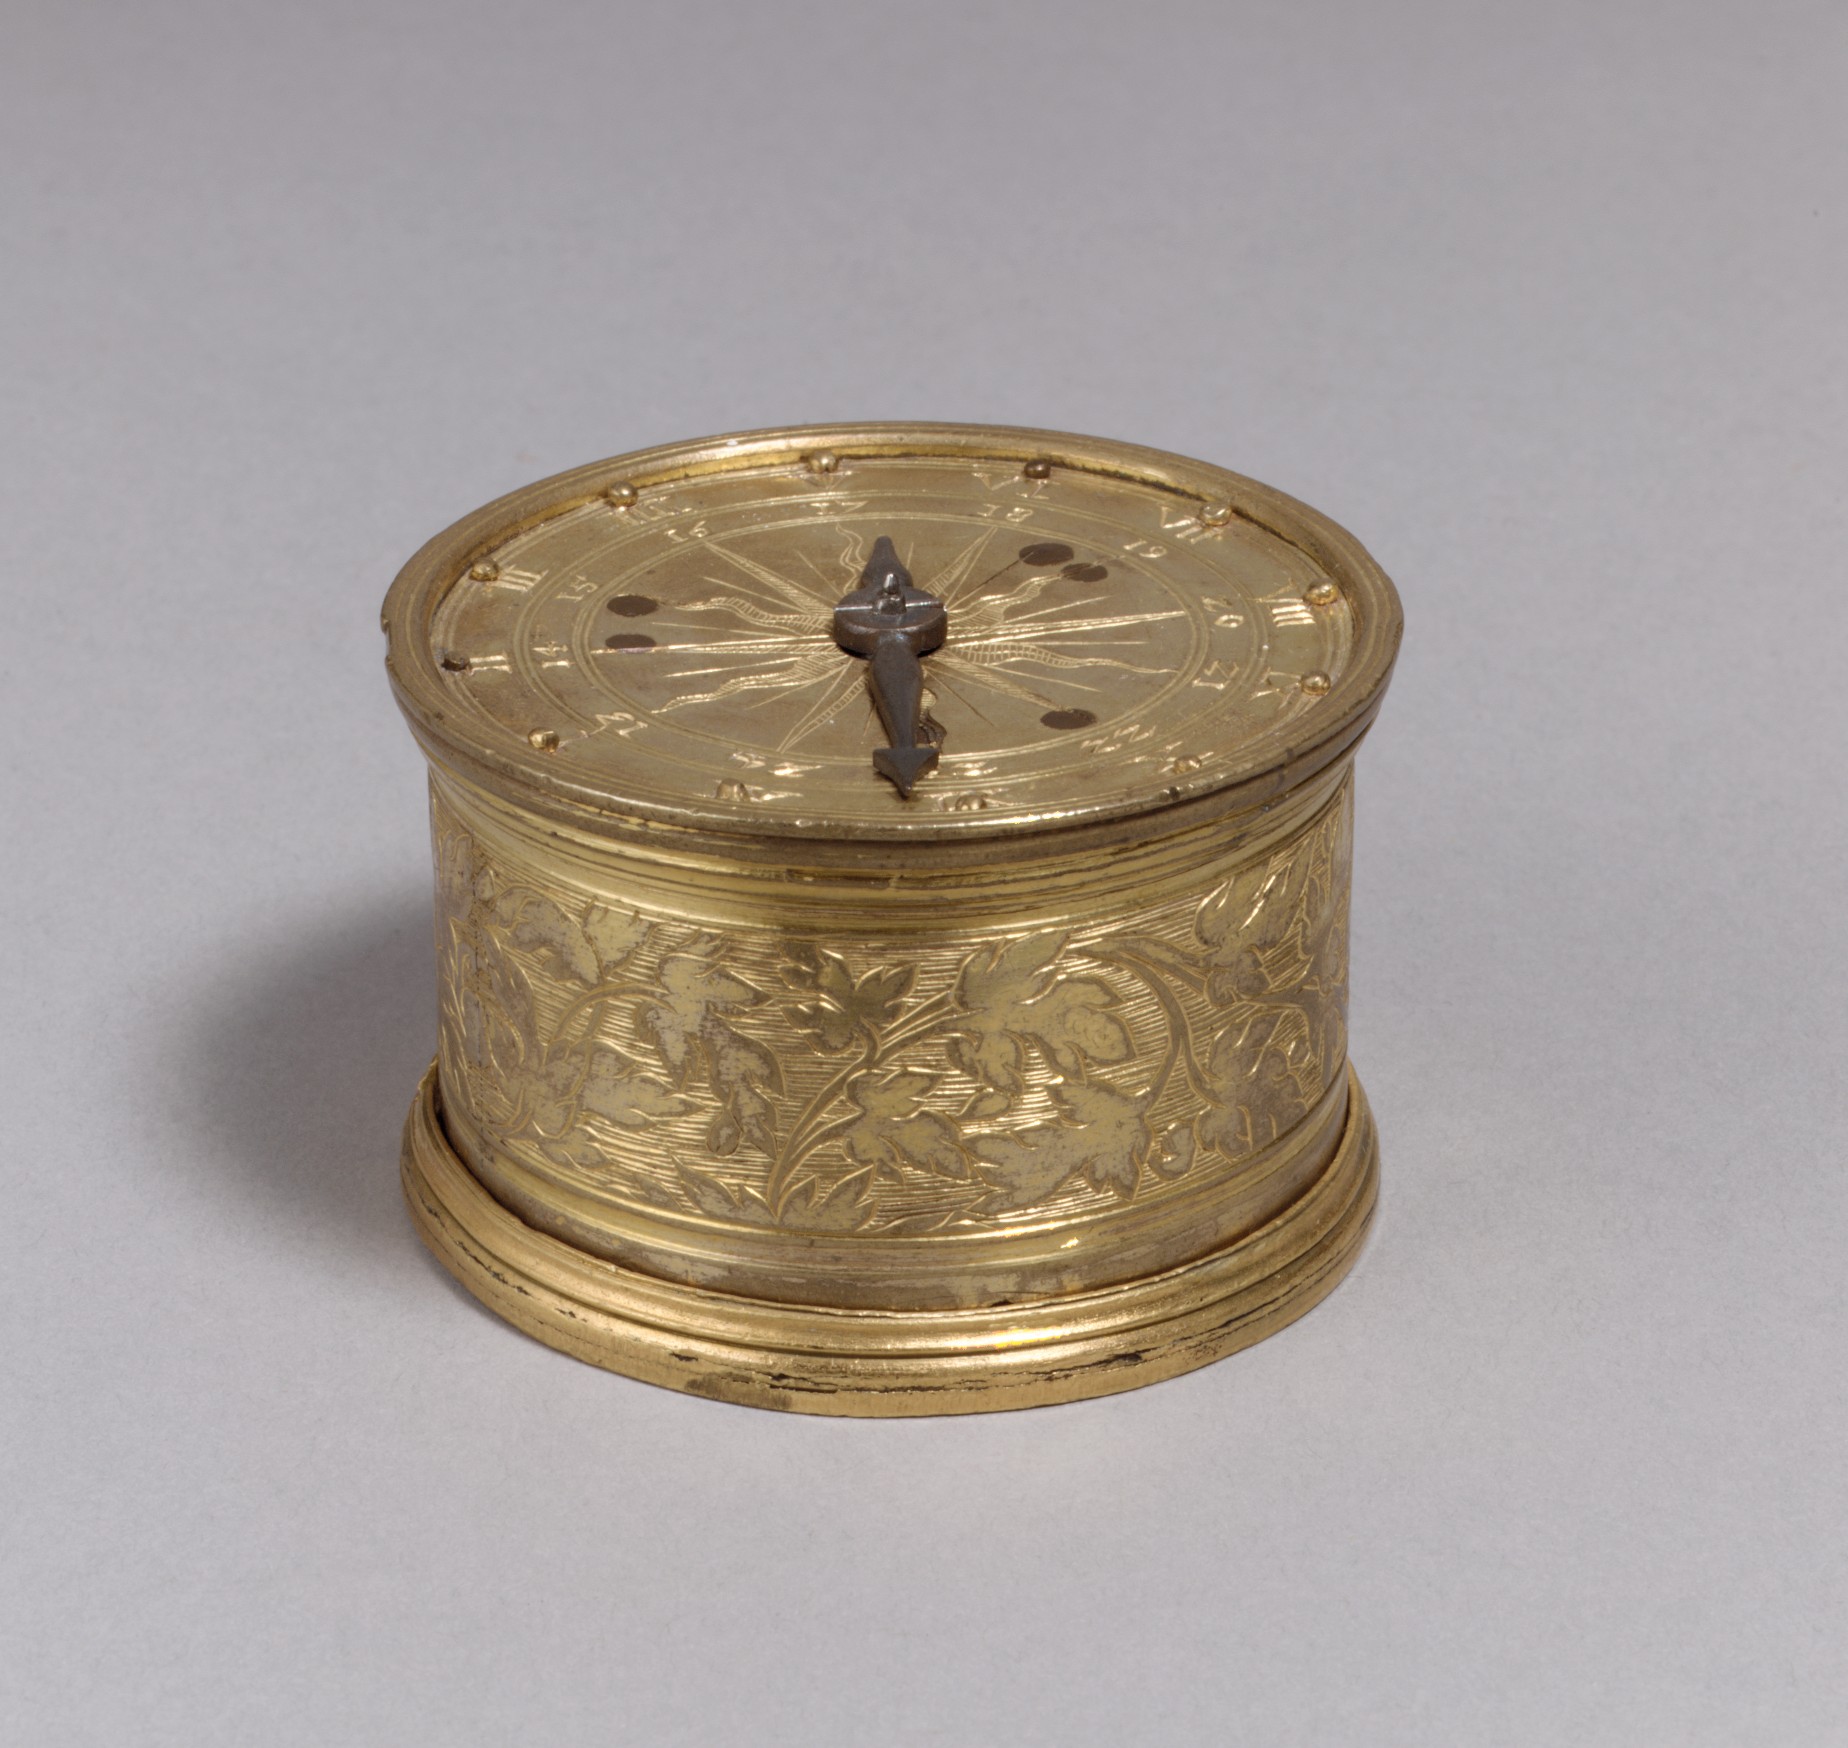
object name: table clock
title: Table clock with skeleton movement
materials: gilt brass, gilt bronze, iron